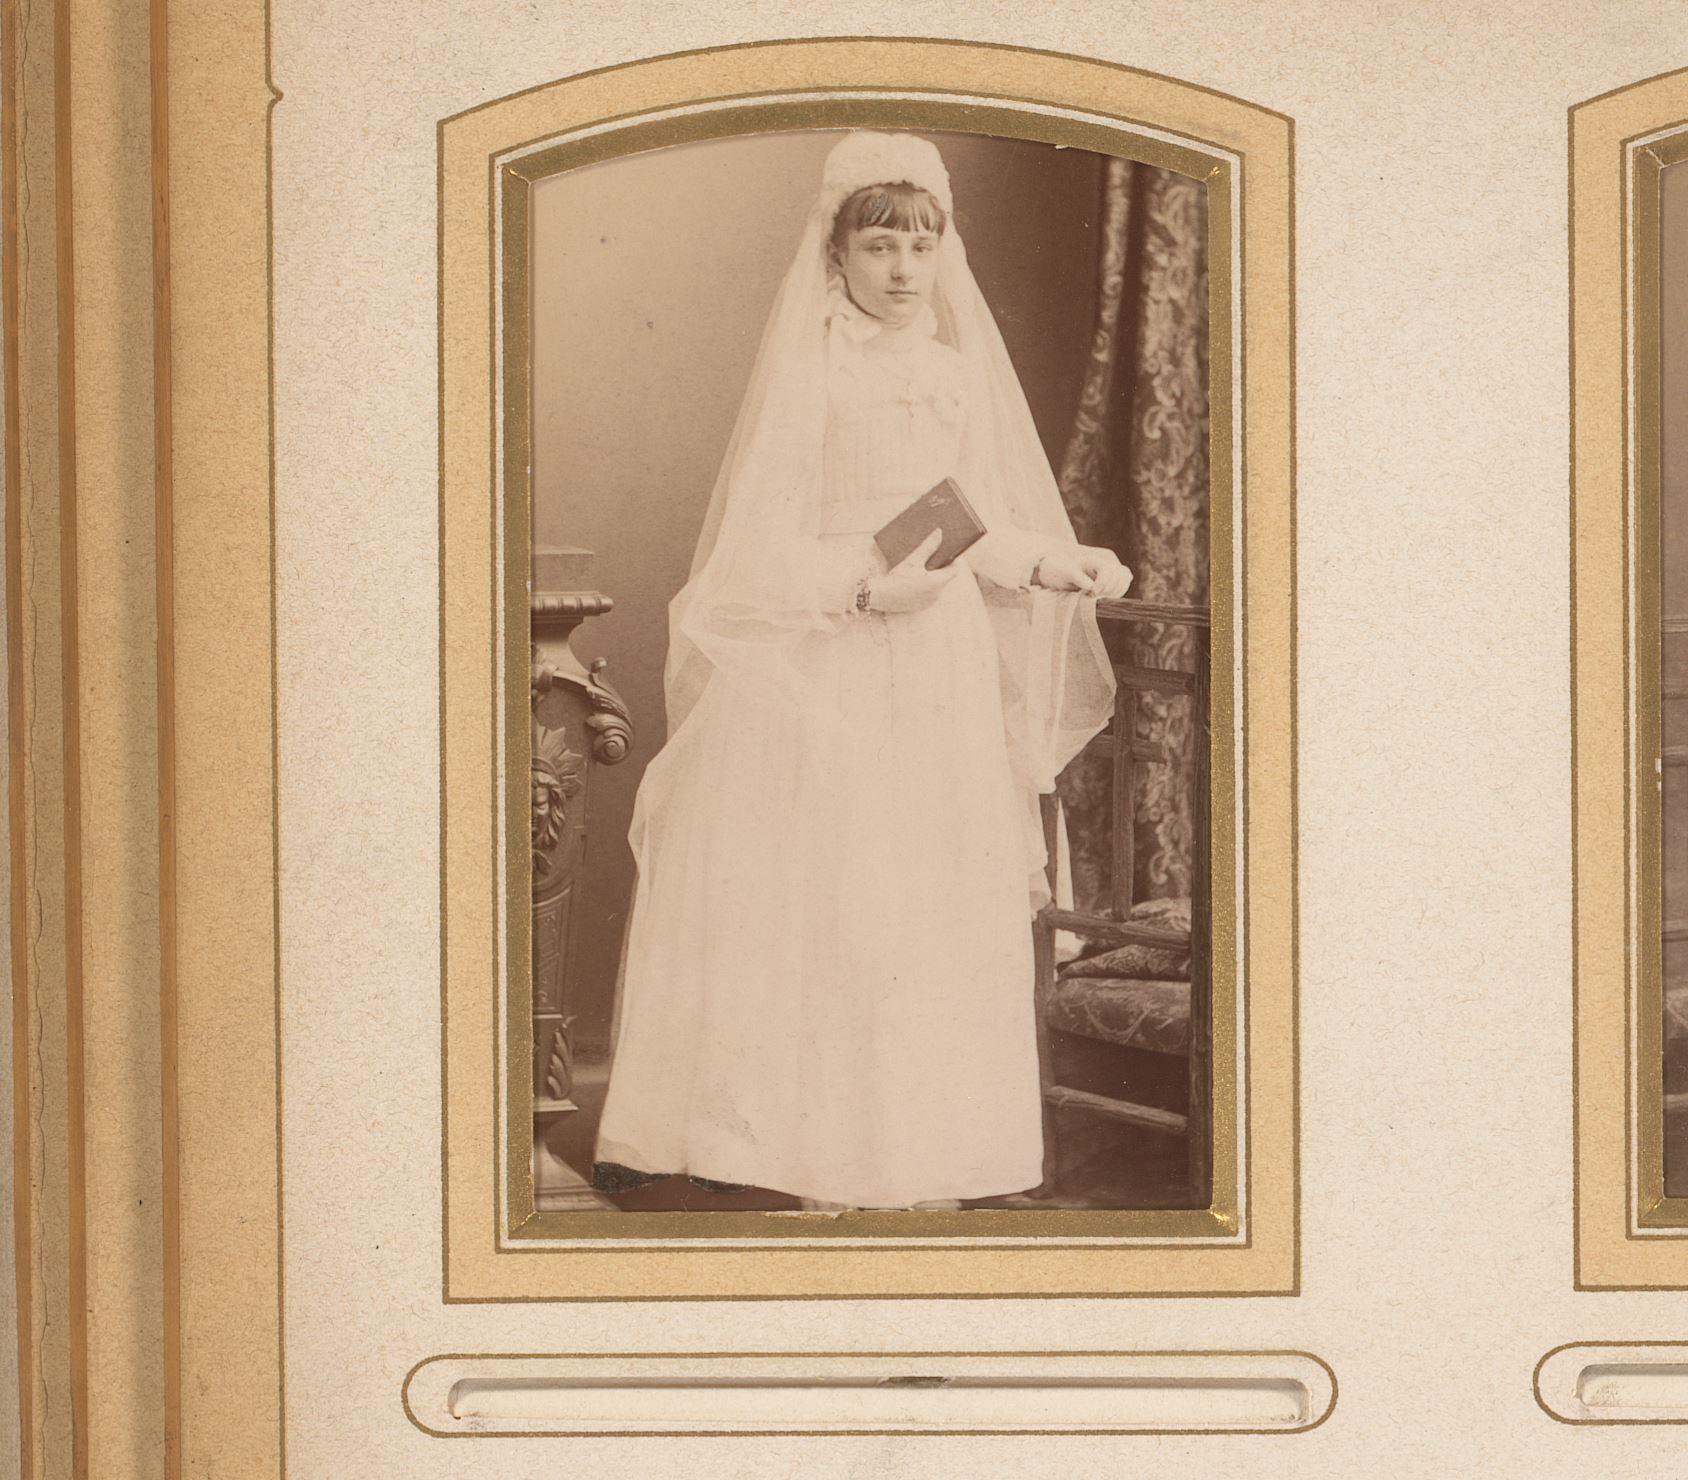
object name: album leaf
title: Portret van een meisje in vermoedelijk een jurk voor de eerste communie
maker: emile schweitzer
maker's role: fotograaf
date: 1860-1900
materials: cardboard, photographic support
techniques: albumen print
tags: clothes for official occasions, historical persons, girl (child between toddler and youth)